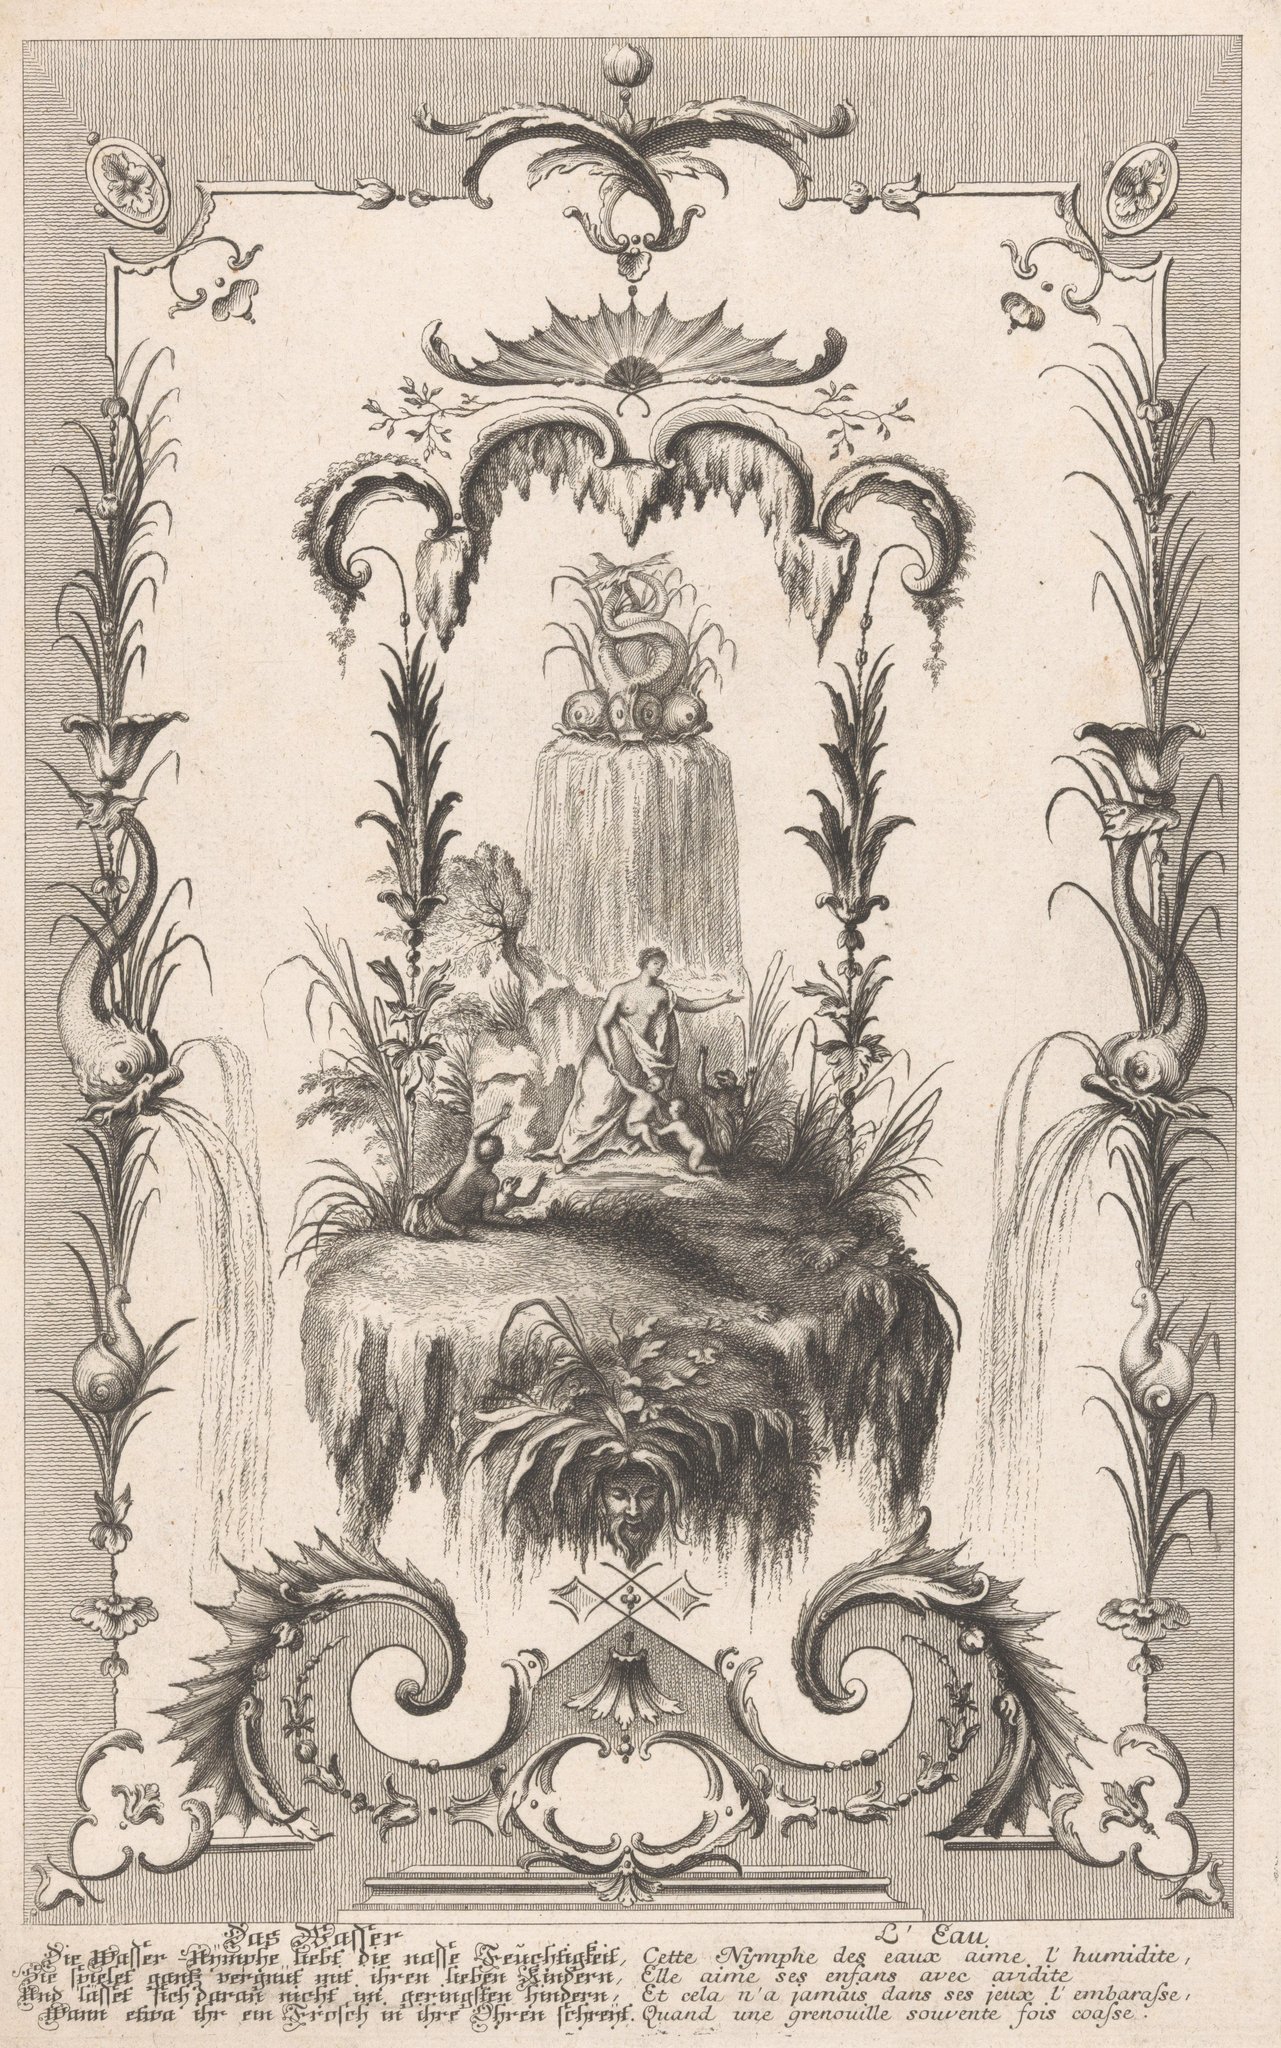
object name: print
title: Water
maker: Anonymous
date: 1729-1800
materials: paper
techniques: etching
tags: dolphin ~ ornament, garden fountain, mother and child(ren), woman and child(ren) (family group), 'acqua', 'carro dell'acqua' (ripa)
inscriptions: collector's mark: Lugt 2228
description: Allegorie van het element water in een omlijsting van planten, slakken en dolfijnen. Een halfnaakte vrouw en drie kinderen staan in een landschap bij een fontein met drie dolfijnen. In de ondermarge tweemaal een vierregelige Duite en Franse tekst.